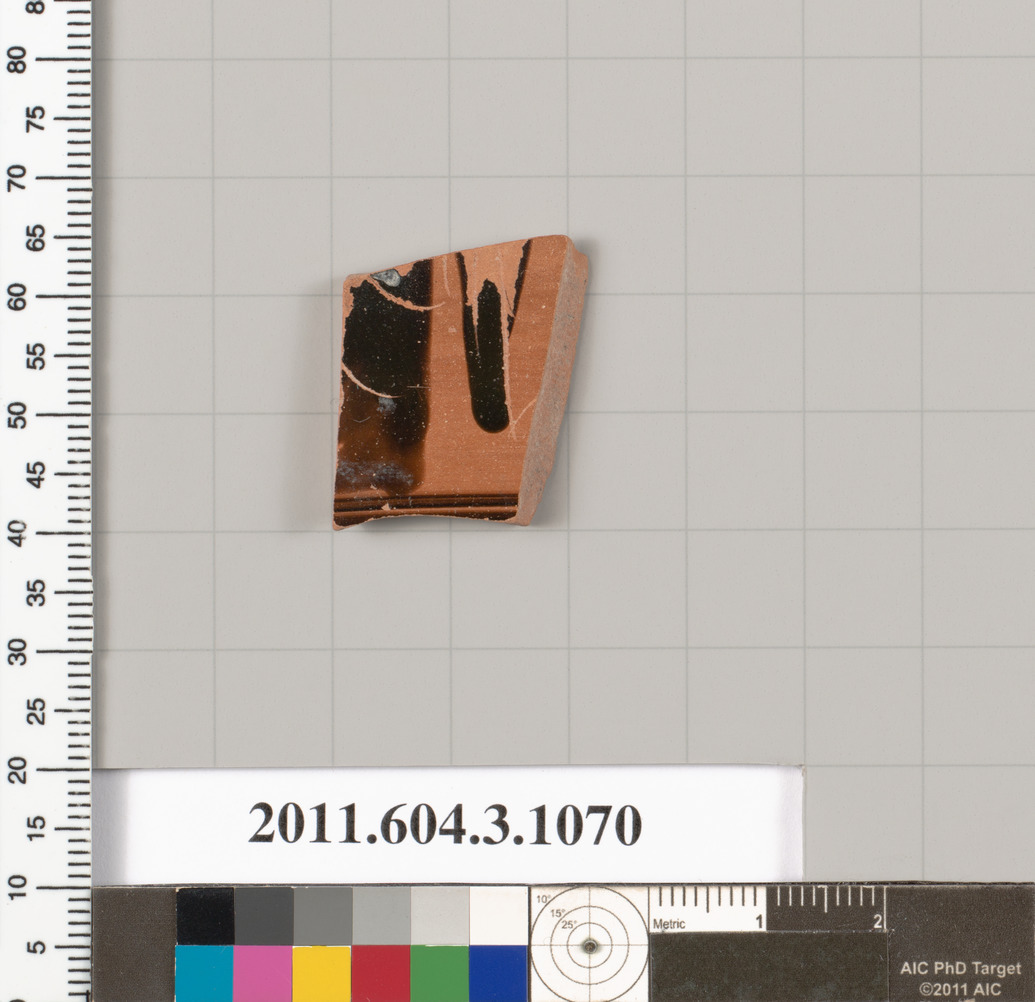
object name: mastoid fragment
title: Terracotta fragment of a mastoid (drinking cup with narrow base)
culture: greek, attic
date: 534-468 BCE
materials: terracotta